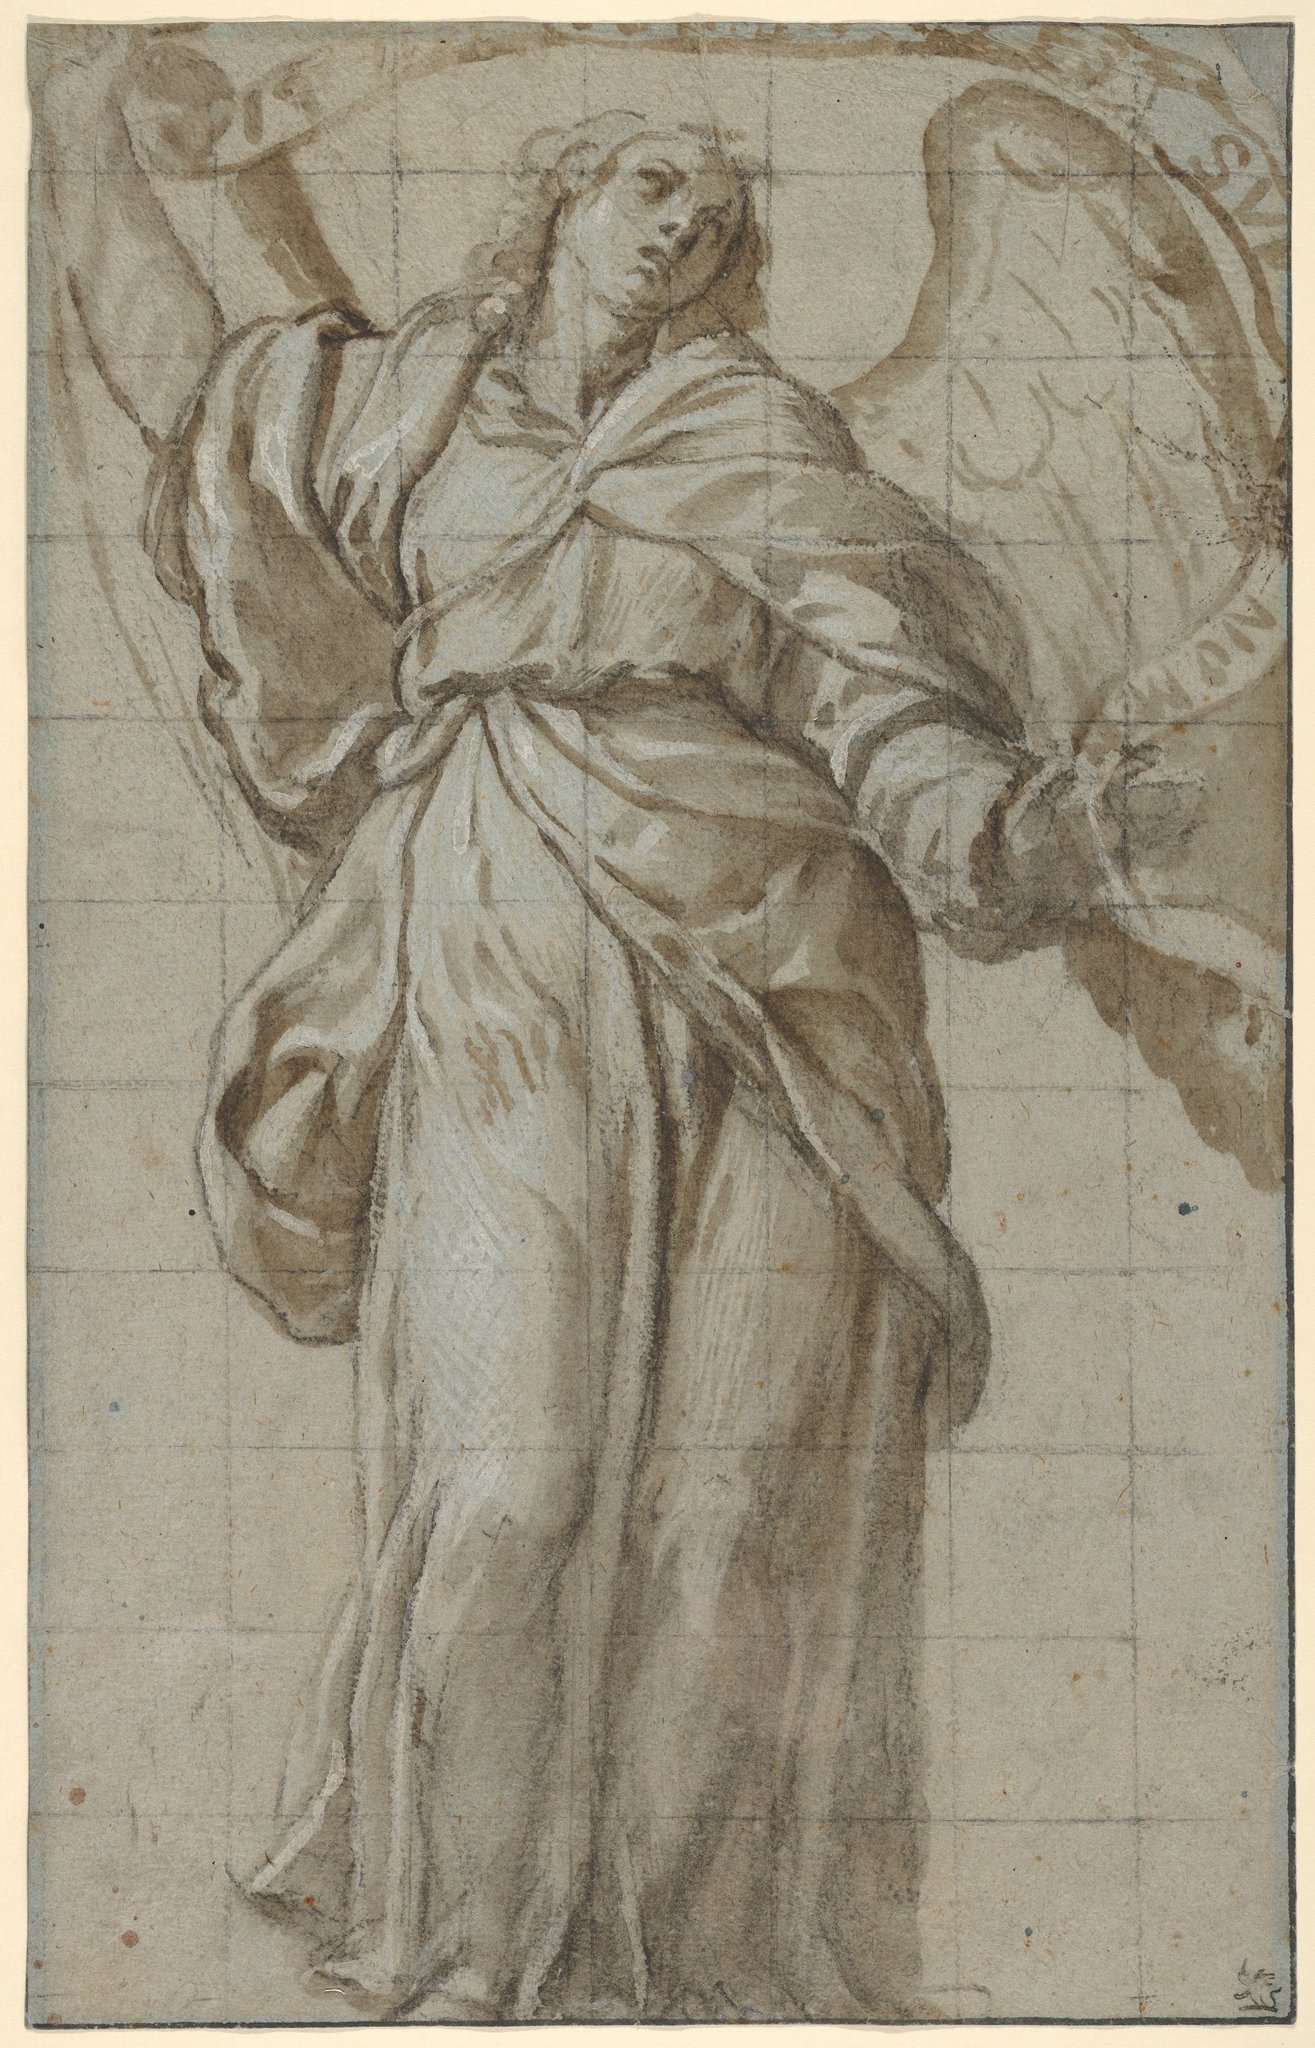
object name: drawing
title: Standing Angel Holding a Scroll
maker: giovanni domenico caresana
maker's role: artist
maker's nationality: italian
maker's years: 1574-1619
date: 1614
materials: chalk, gouache, paper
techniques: brush, highlighting, drawing, wash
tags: angels